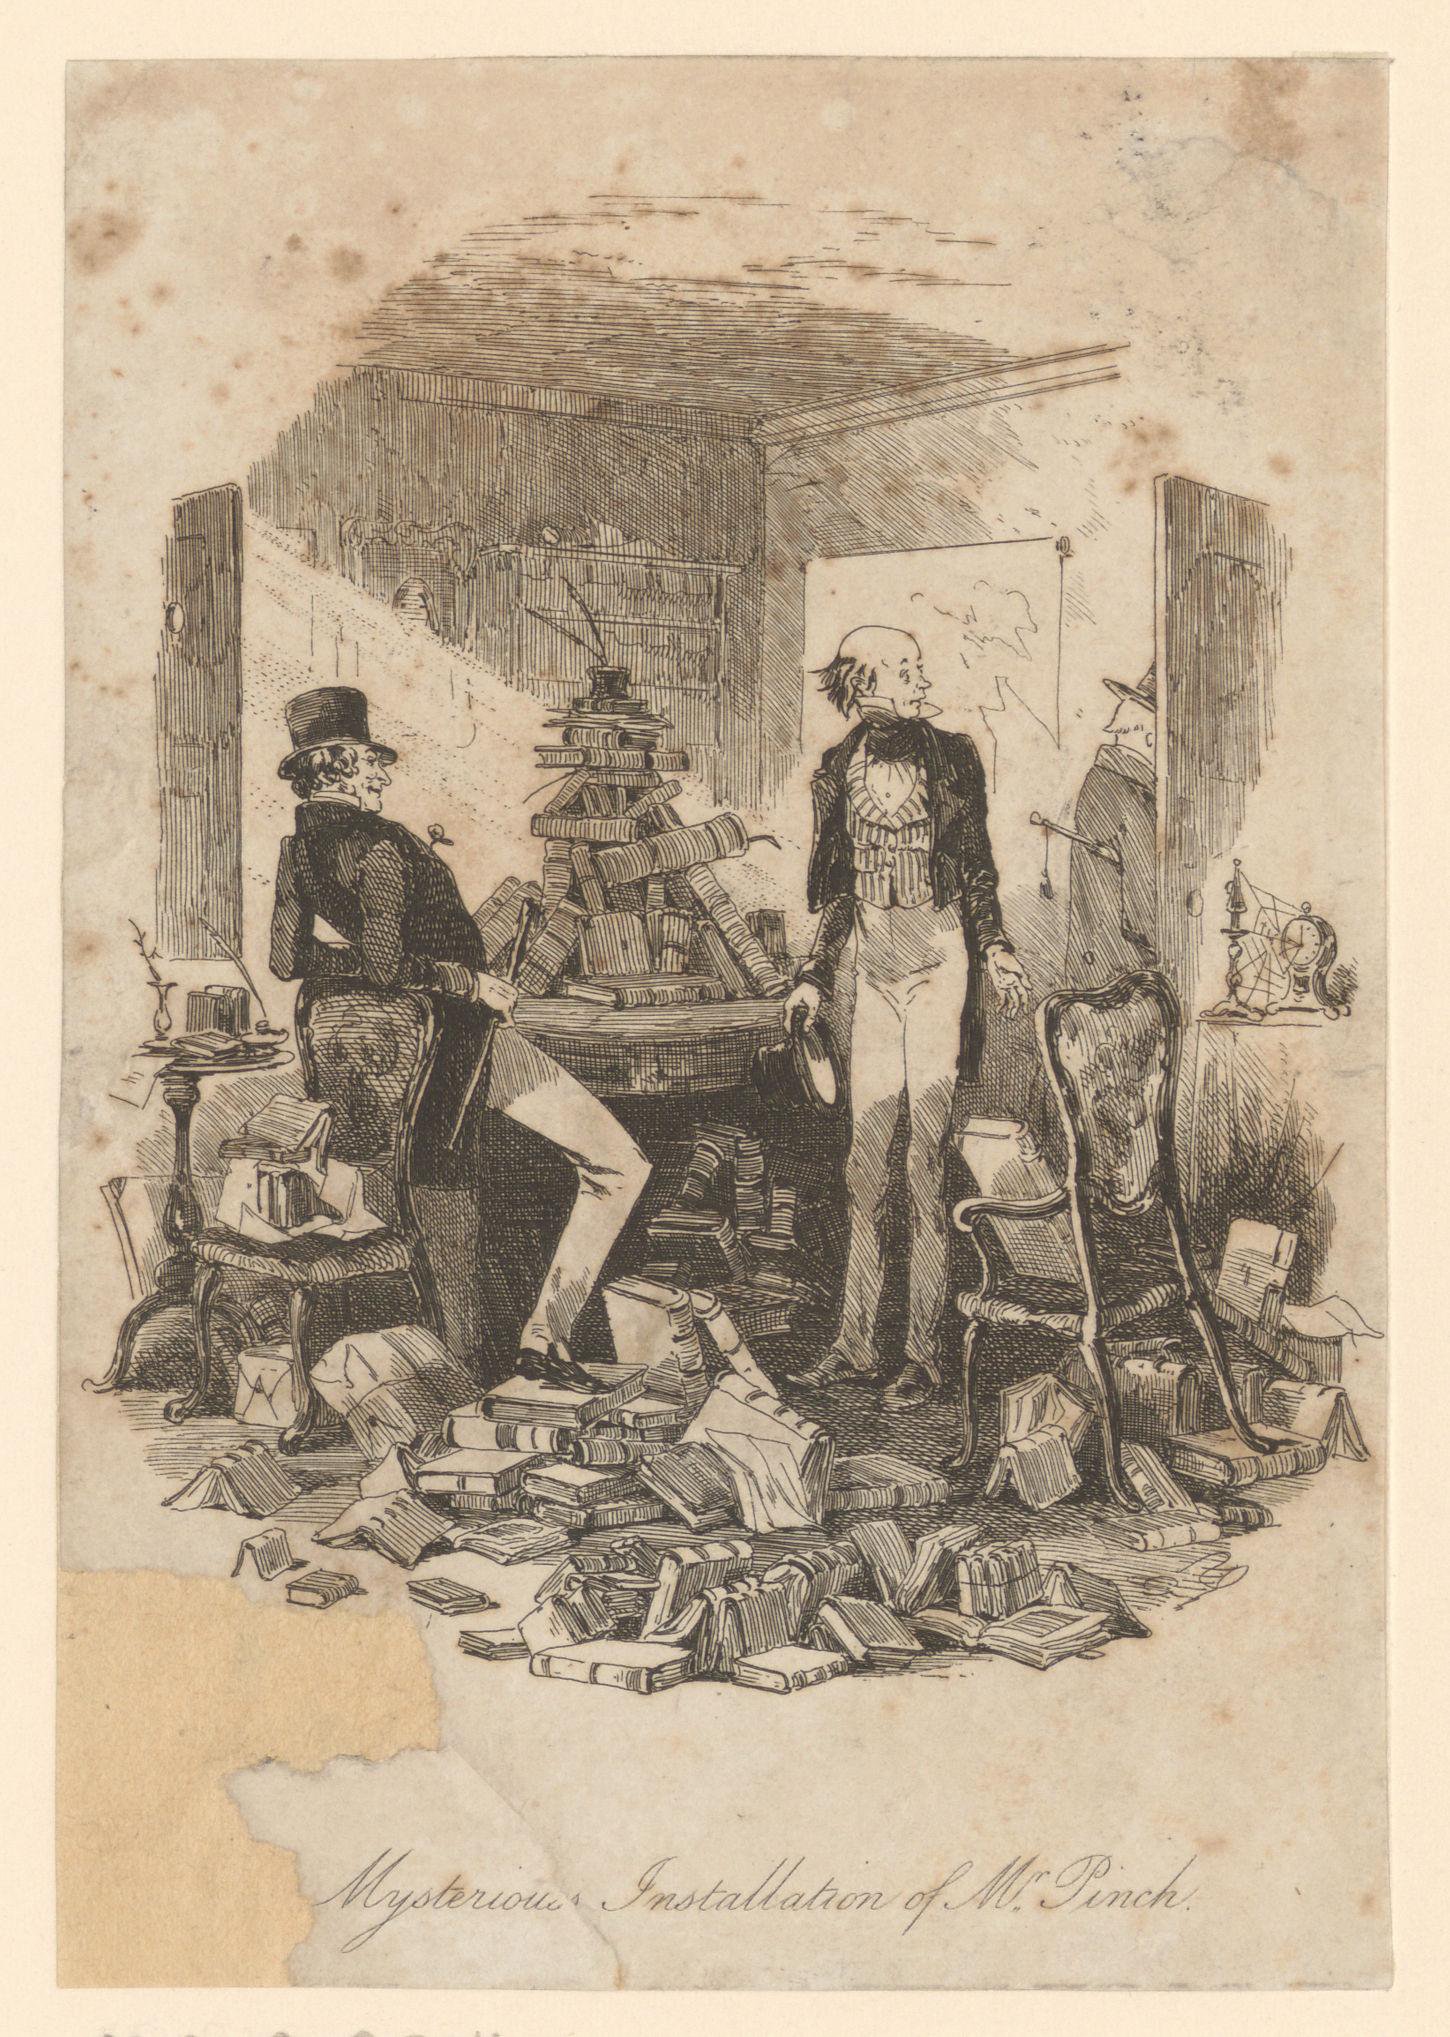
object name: print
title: Mysterious Installation of Mr. Pinch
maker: hablot knight browne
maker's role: print maker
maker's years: 1815-1882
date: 1803-1844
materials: paper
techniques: etching, roulette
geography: london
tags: book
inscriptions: collector's mark: Lugt 2228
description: Prent uit: Dickens, Charles. Nicholas Nickleby. Londen: Chapman and Hall, 1839. Het boek werd eerst in delen uitgegeven vanaf maart 1838.